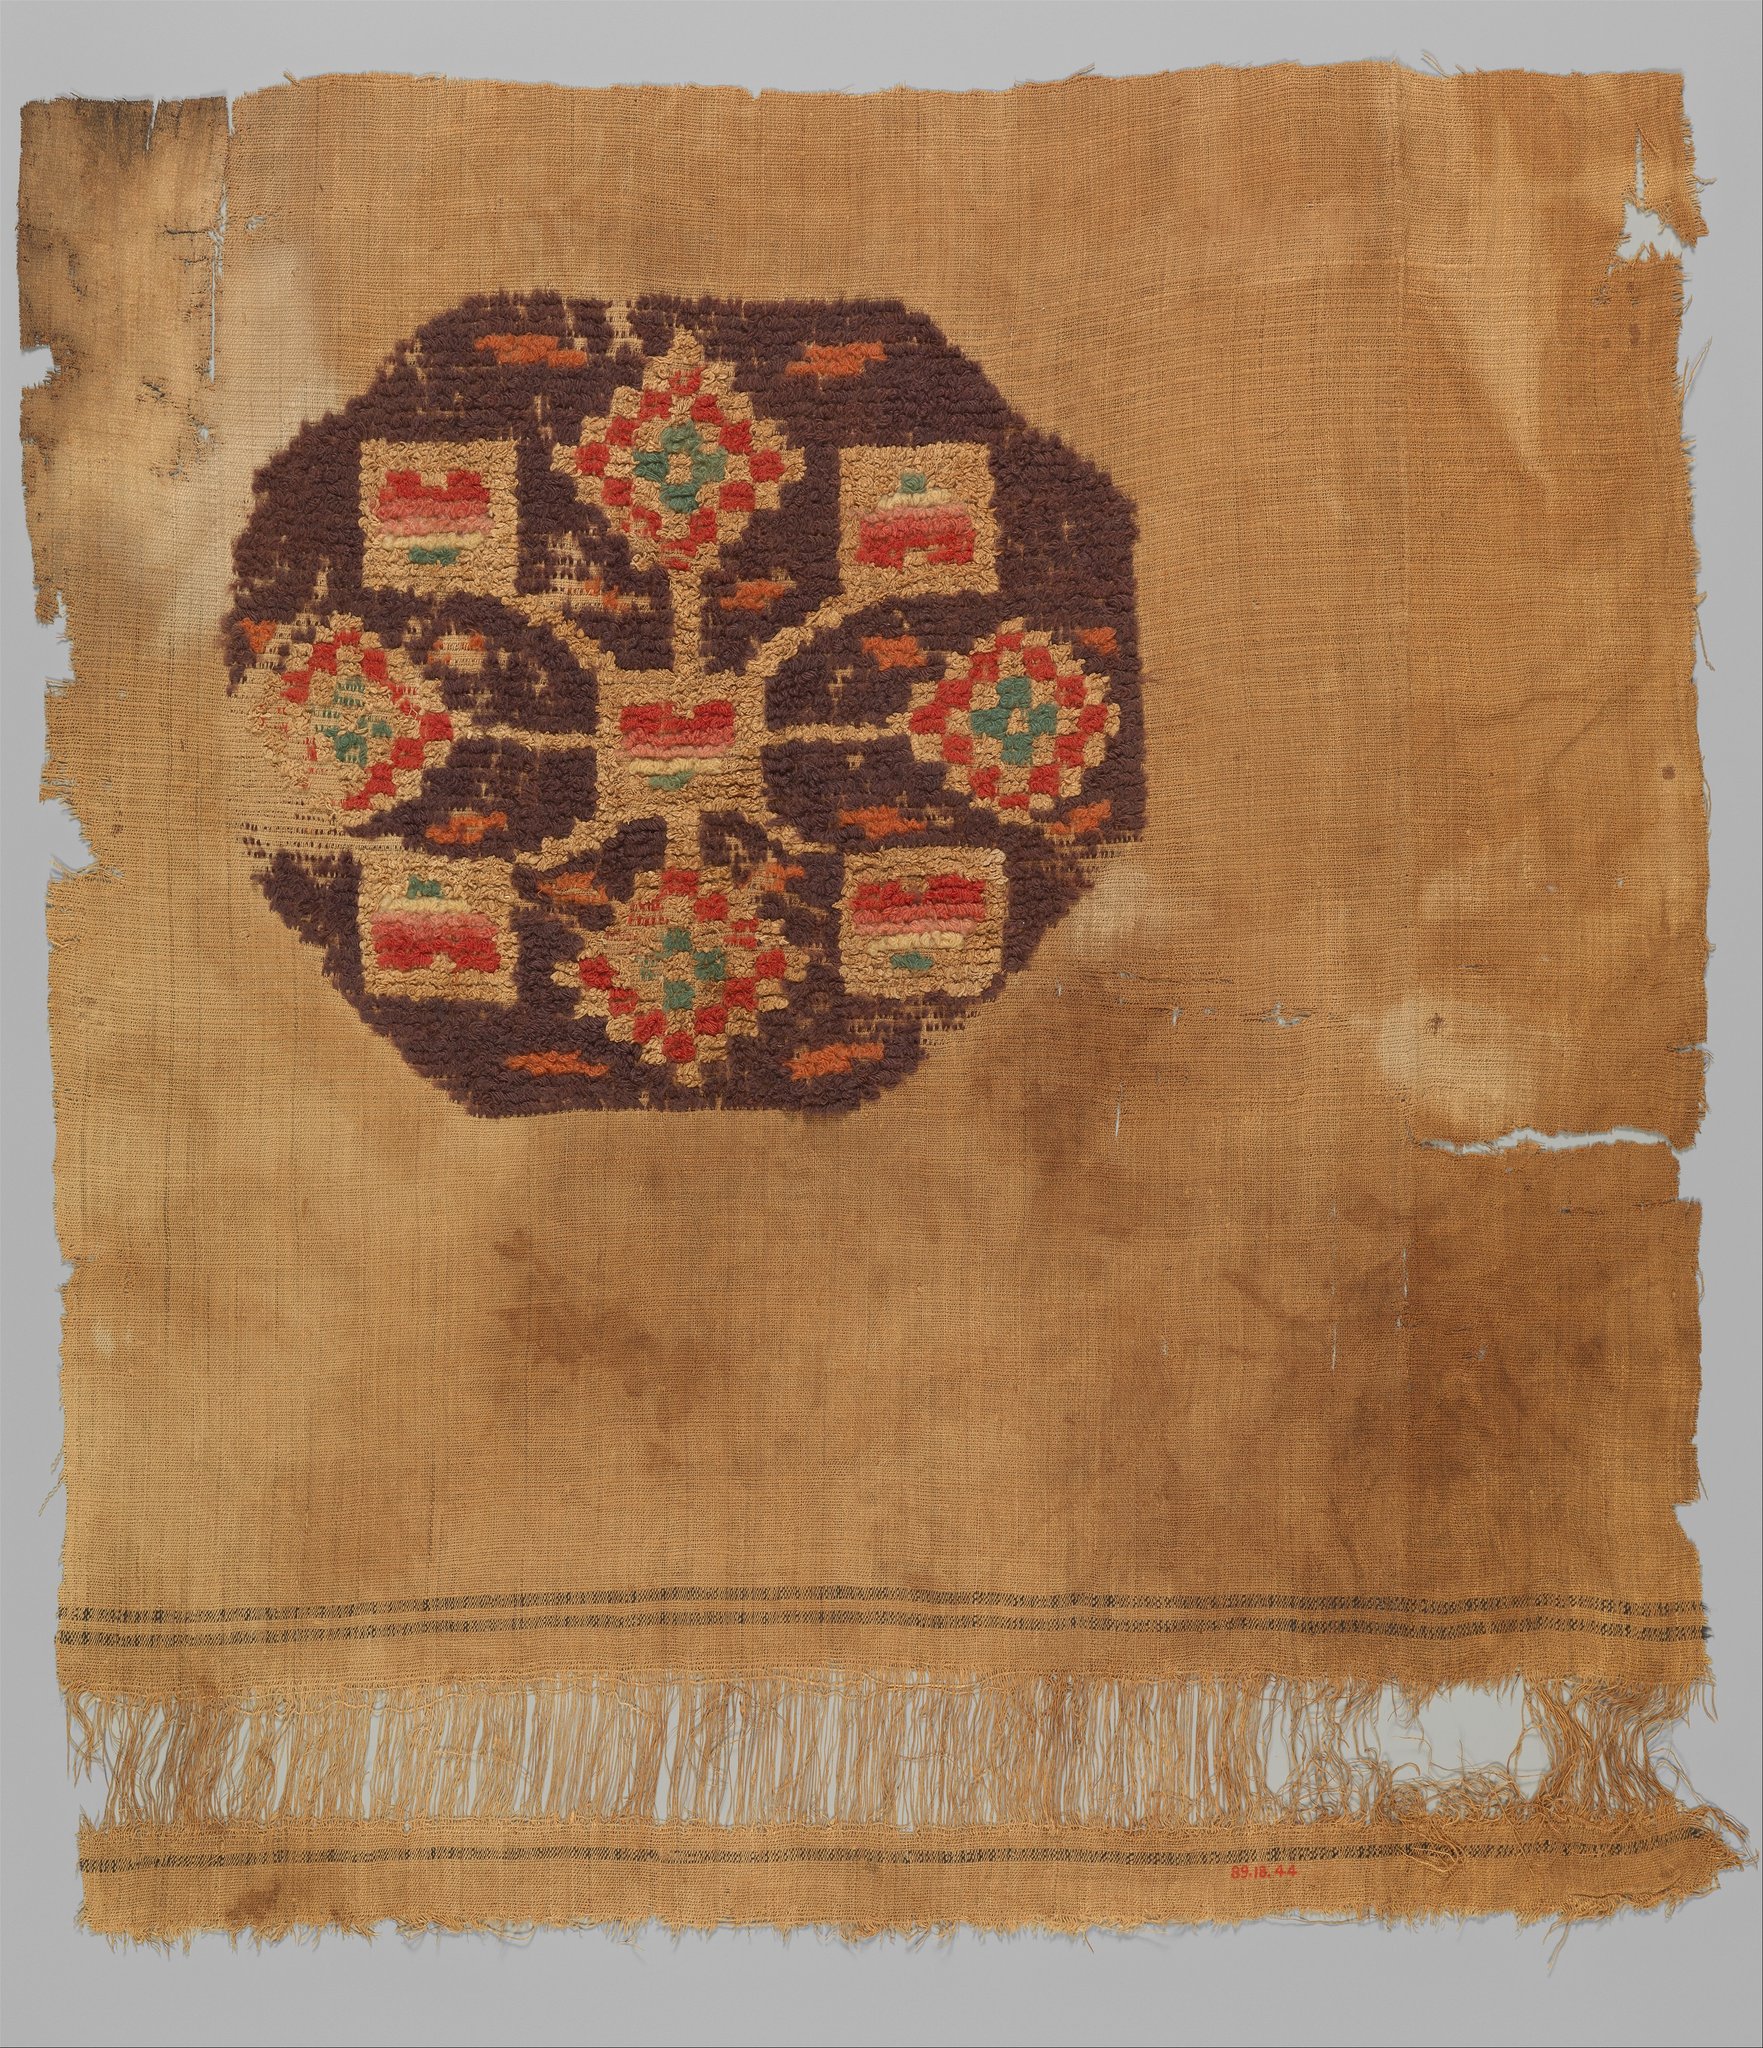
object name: textile fragment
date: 301-500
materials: linen, wool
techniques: weave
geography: egypt